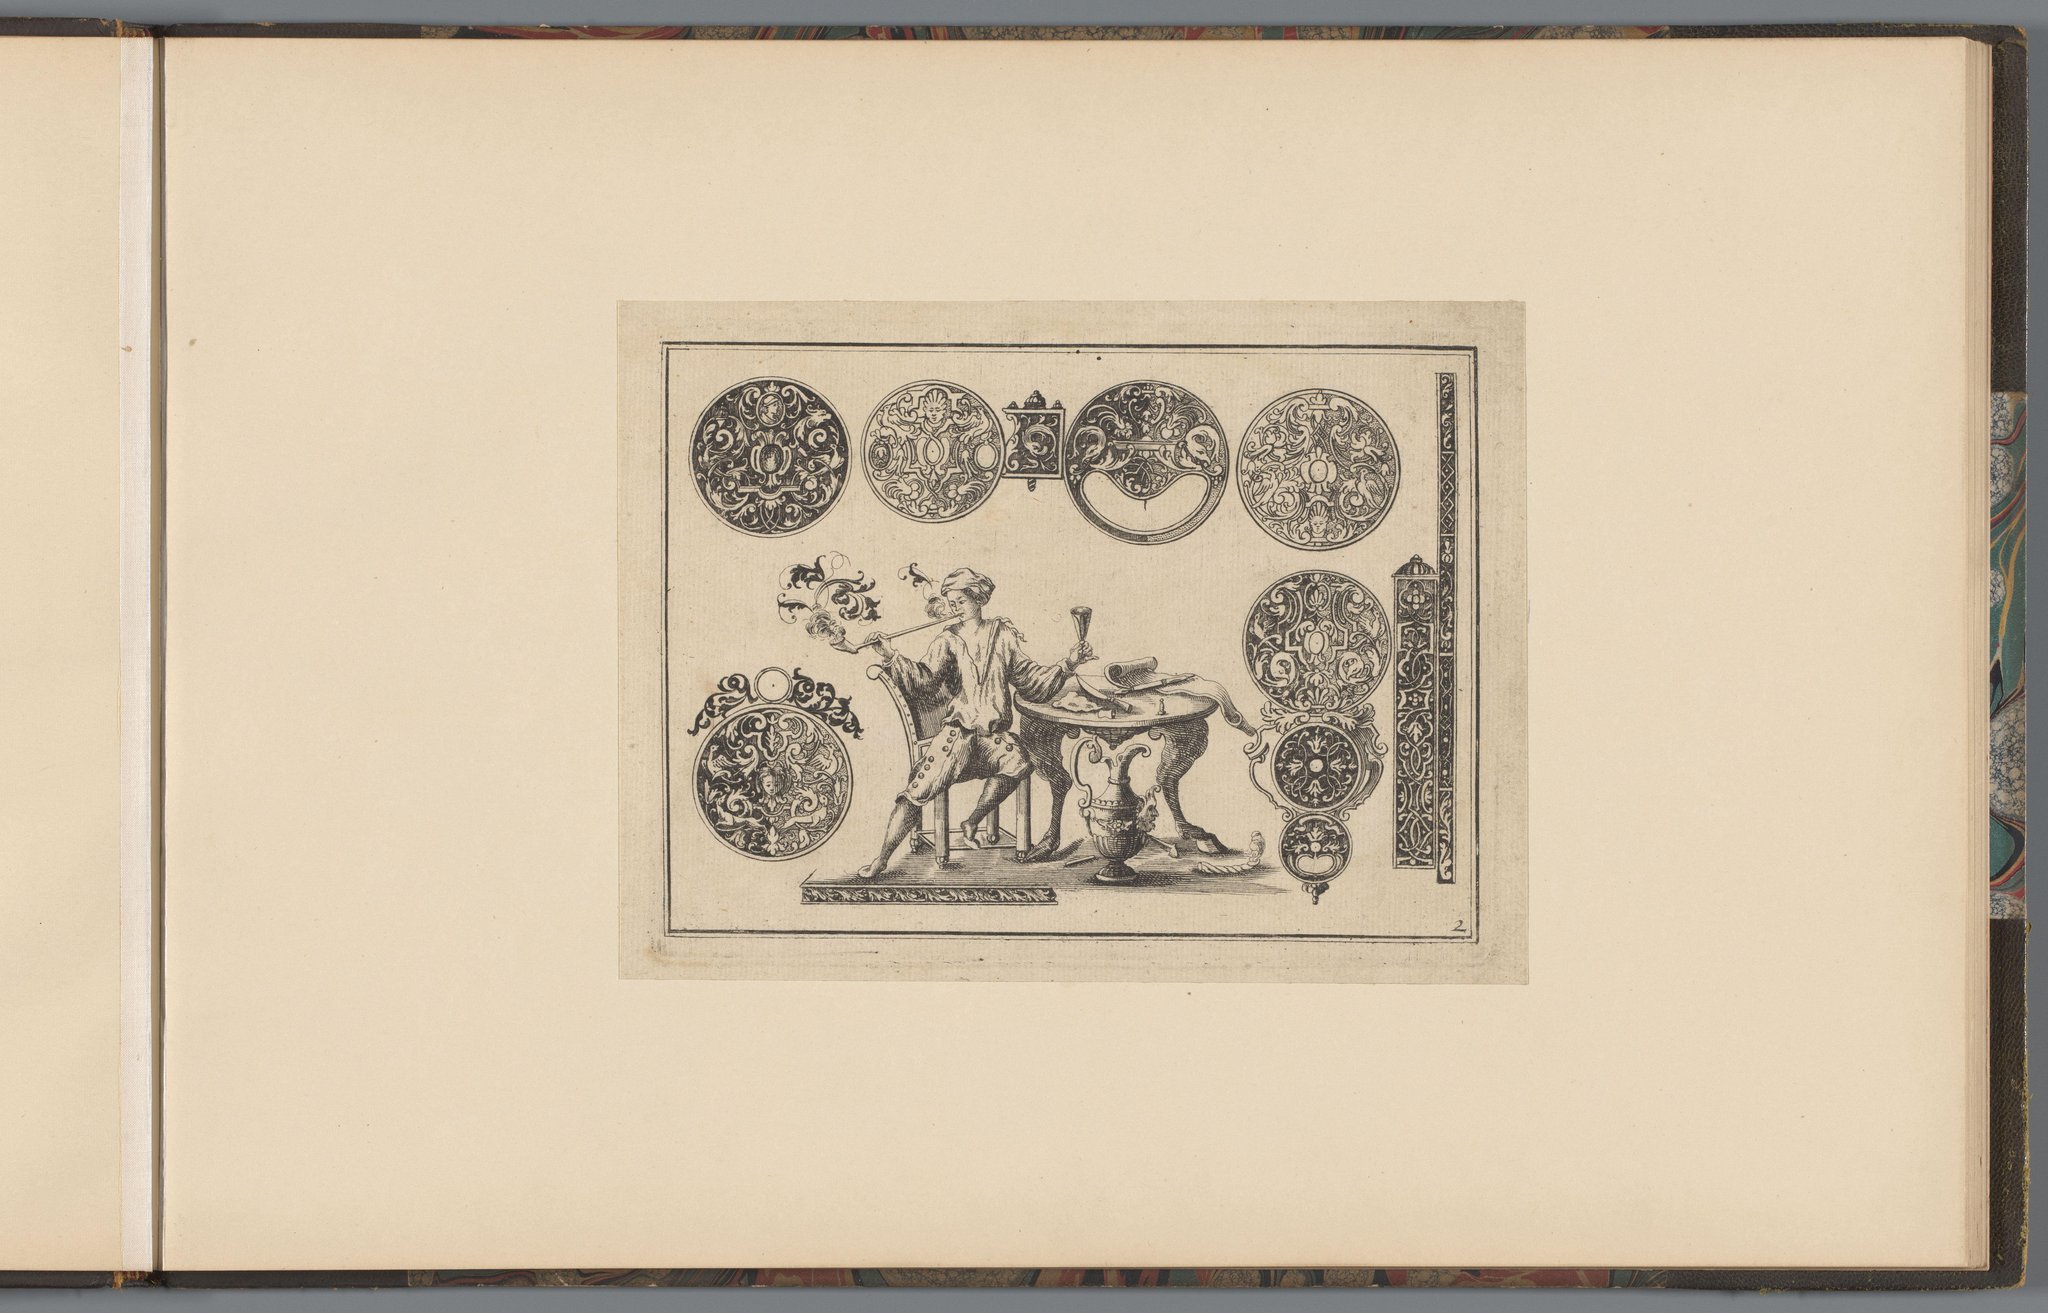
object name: album leaf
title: ontwerpen voor horlogekasten omringende een rokende en drinkende man aan tafel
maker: johann lorenz hönnig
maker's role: print maker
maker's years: 1674-1713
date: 1707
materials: paper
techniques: engraving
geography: nuremberg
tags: ornaments ~ art, pipe ~ tobacco, watch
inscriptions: number: ‘2’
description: Zwartornamenten. Prent maakt deel uit van een album.